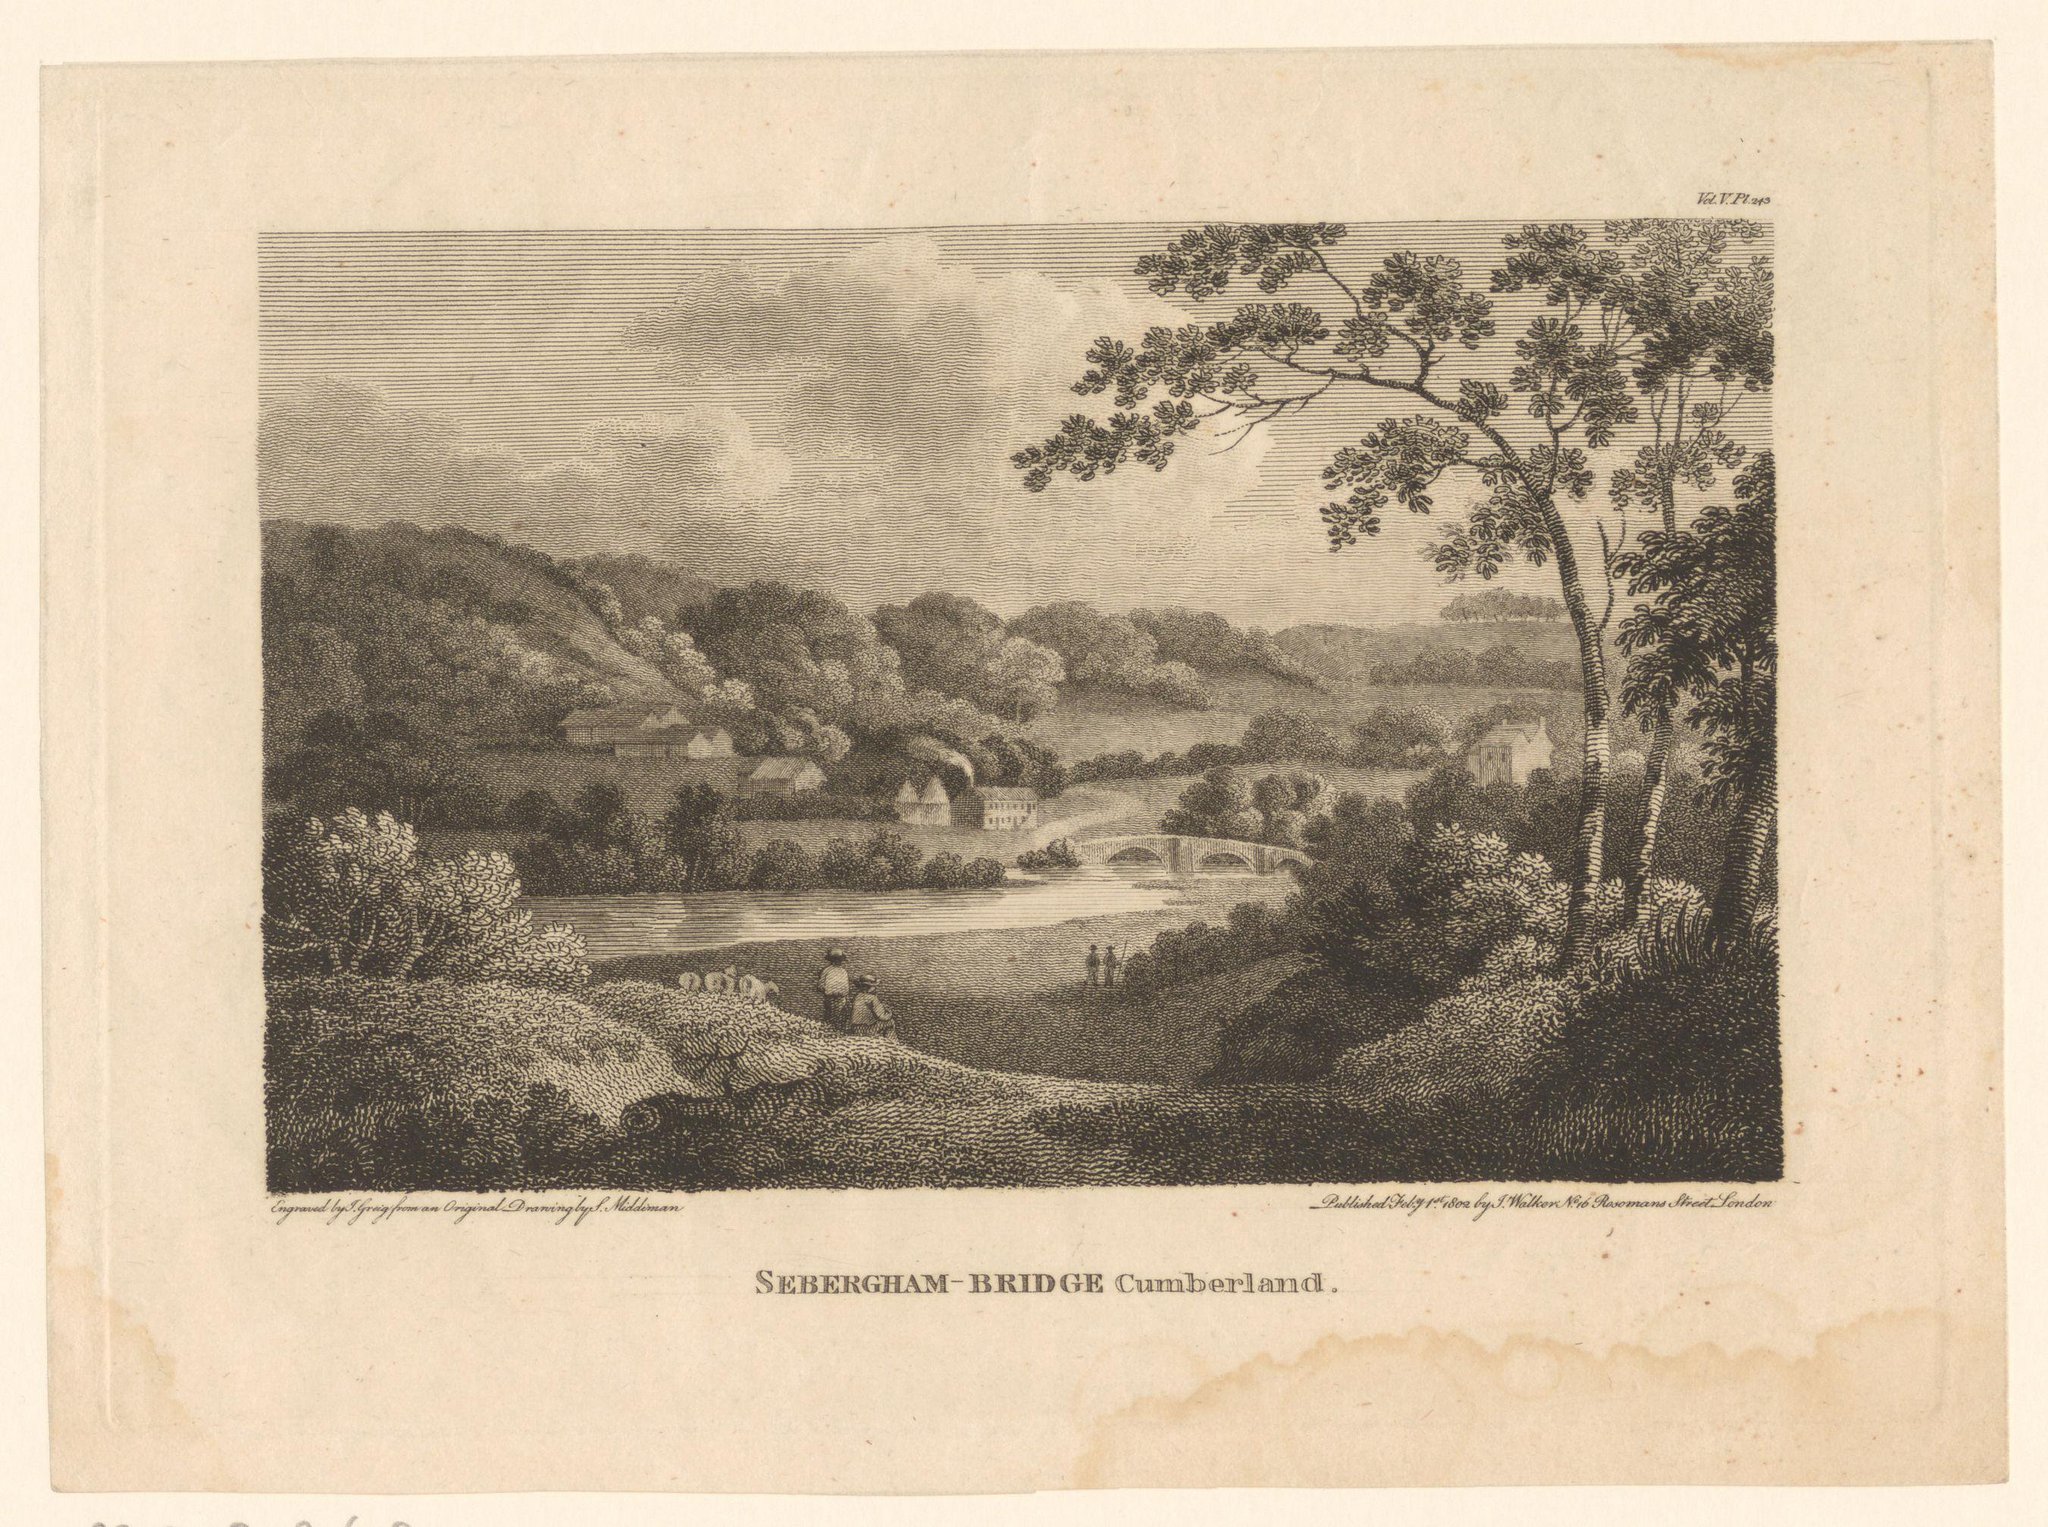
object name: print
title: Landschap met de rivier Caldew en de brug van Sebergham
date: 1802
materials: paper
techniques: etching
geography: london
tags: river, bridge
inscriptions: collector's mark: Lugt 2228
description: Prent uit: The Copper-plate Magazine, 1802.